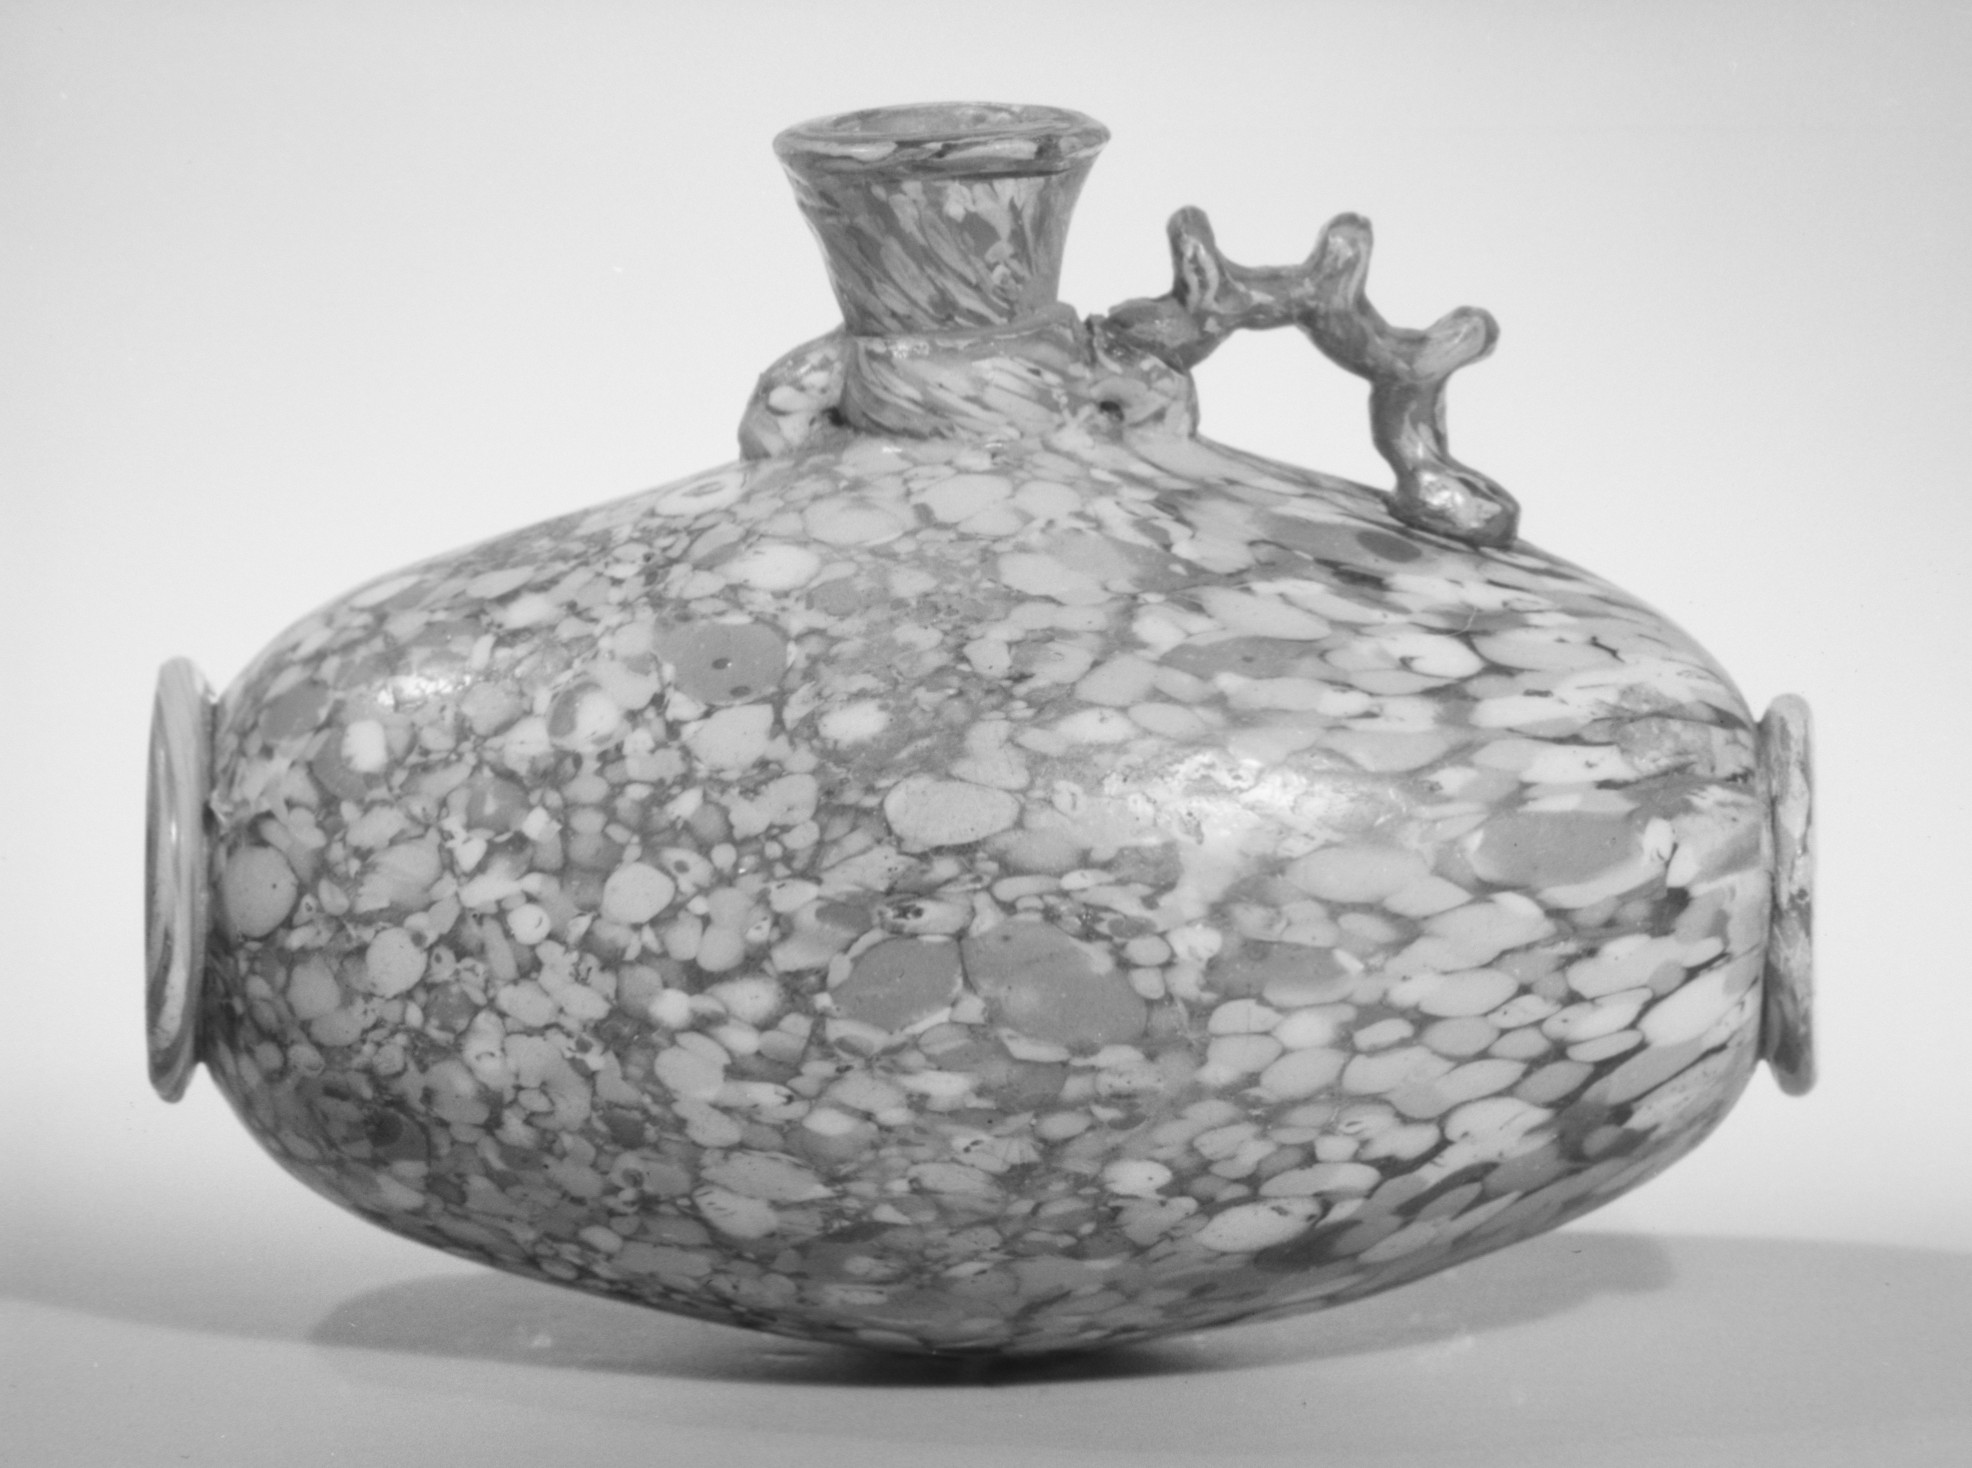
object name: flask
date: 1601-1700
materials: glass